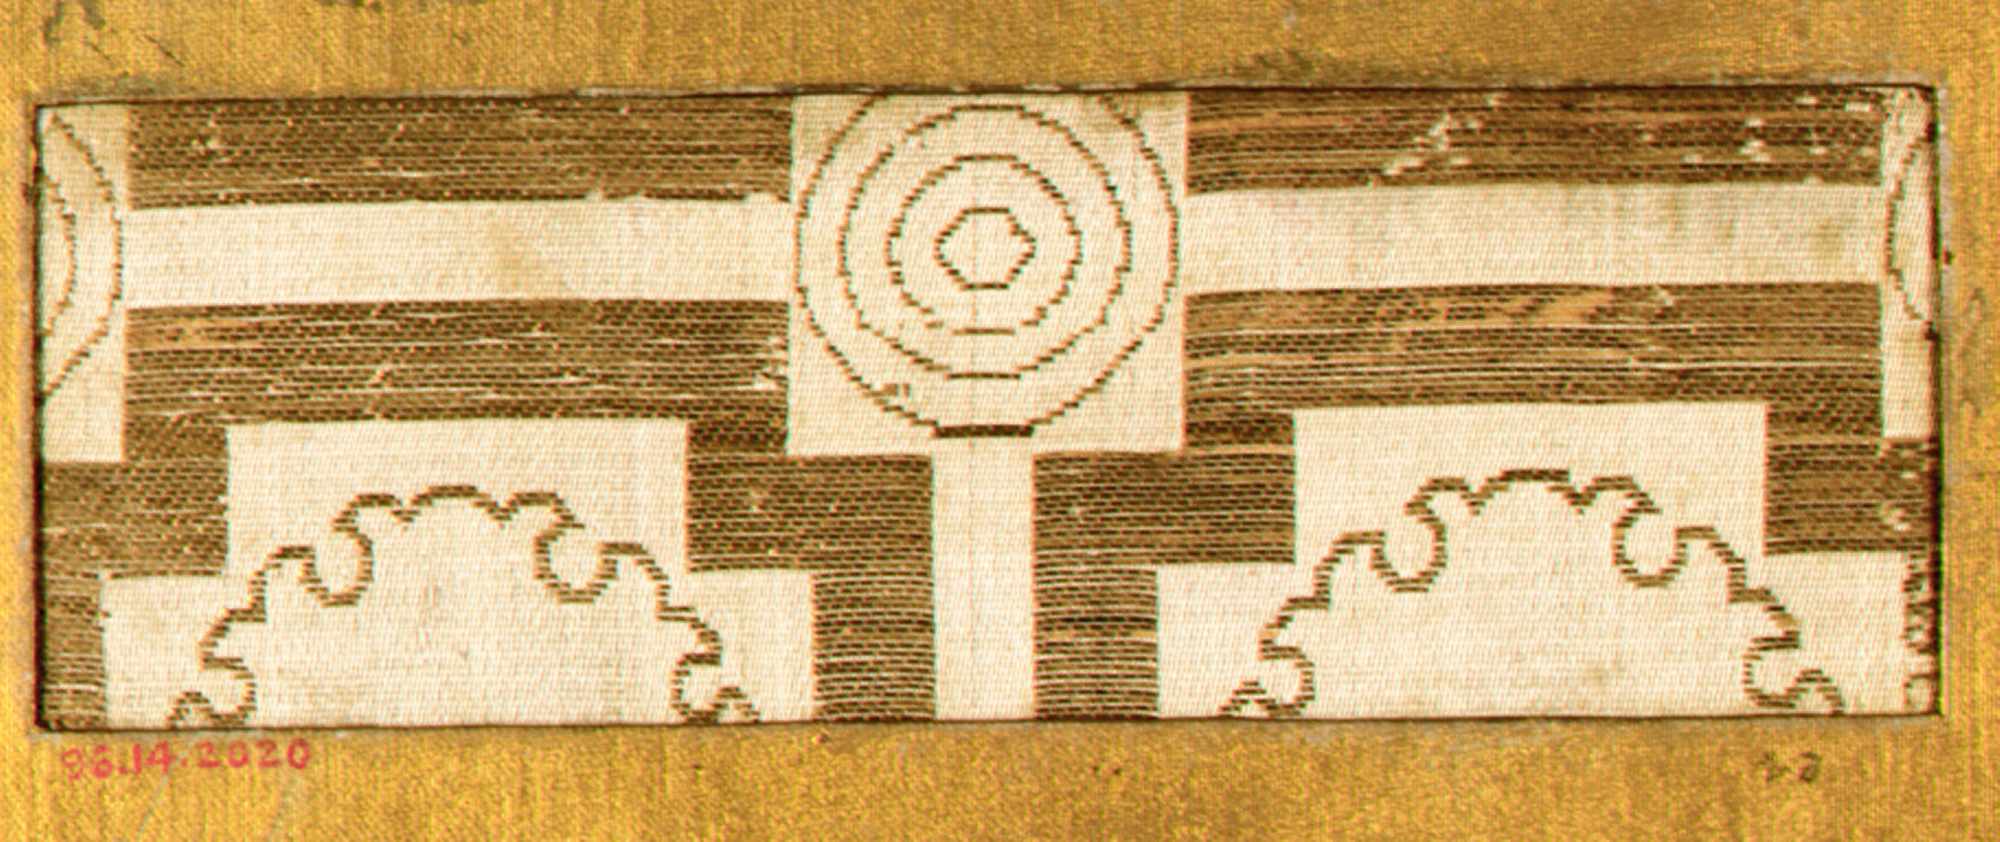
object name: piece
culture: japanese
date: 1701-1900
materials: silk